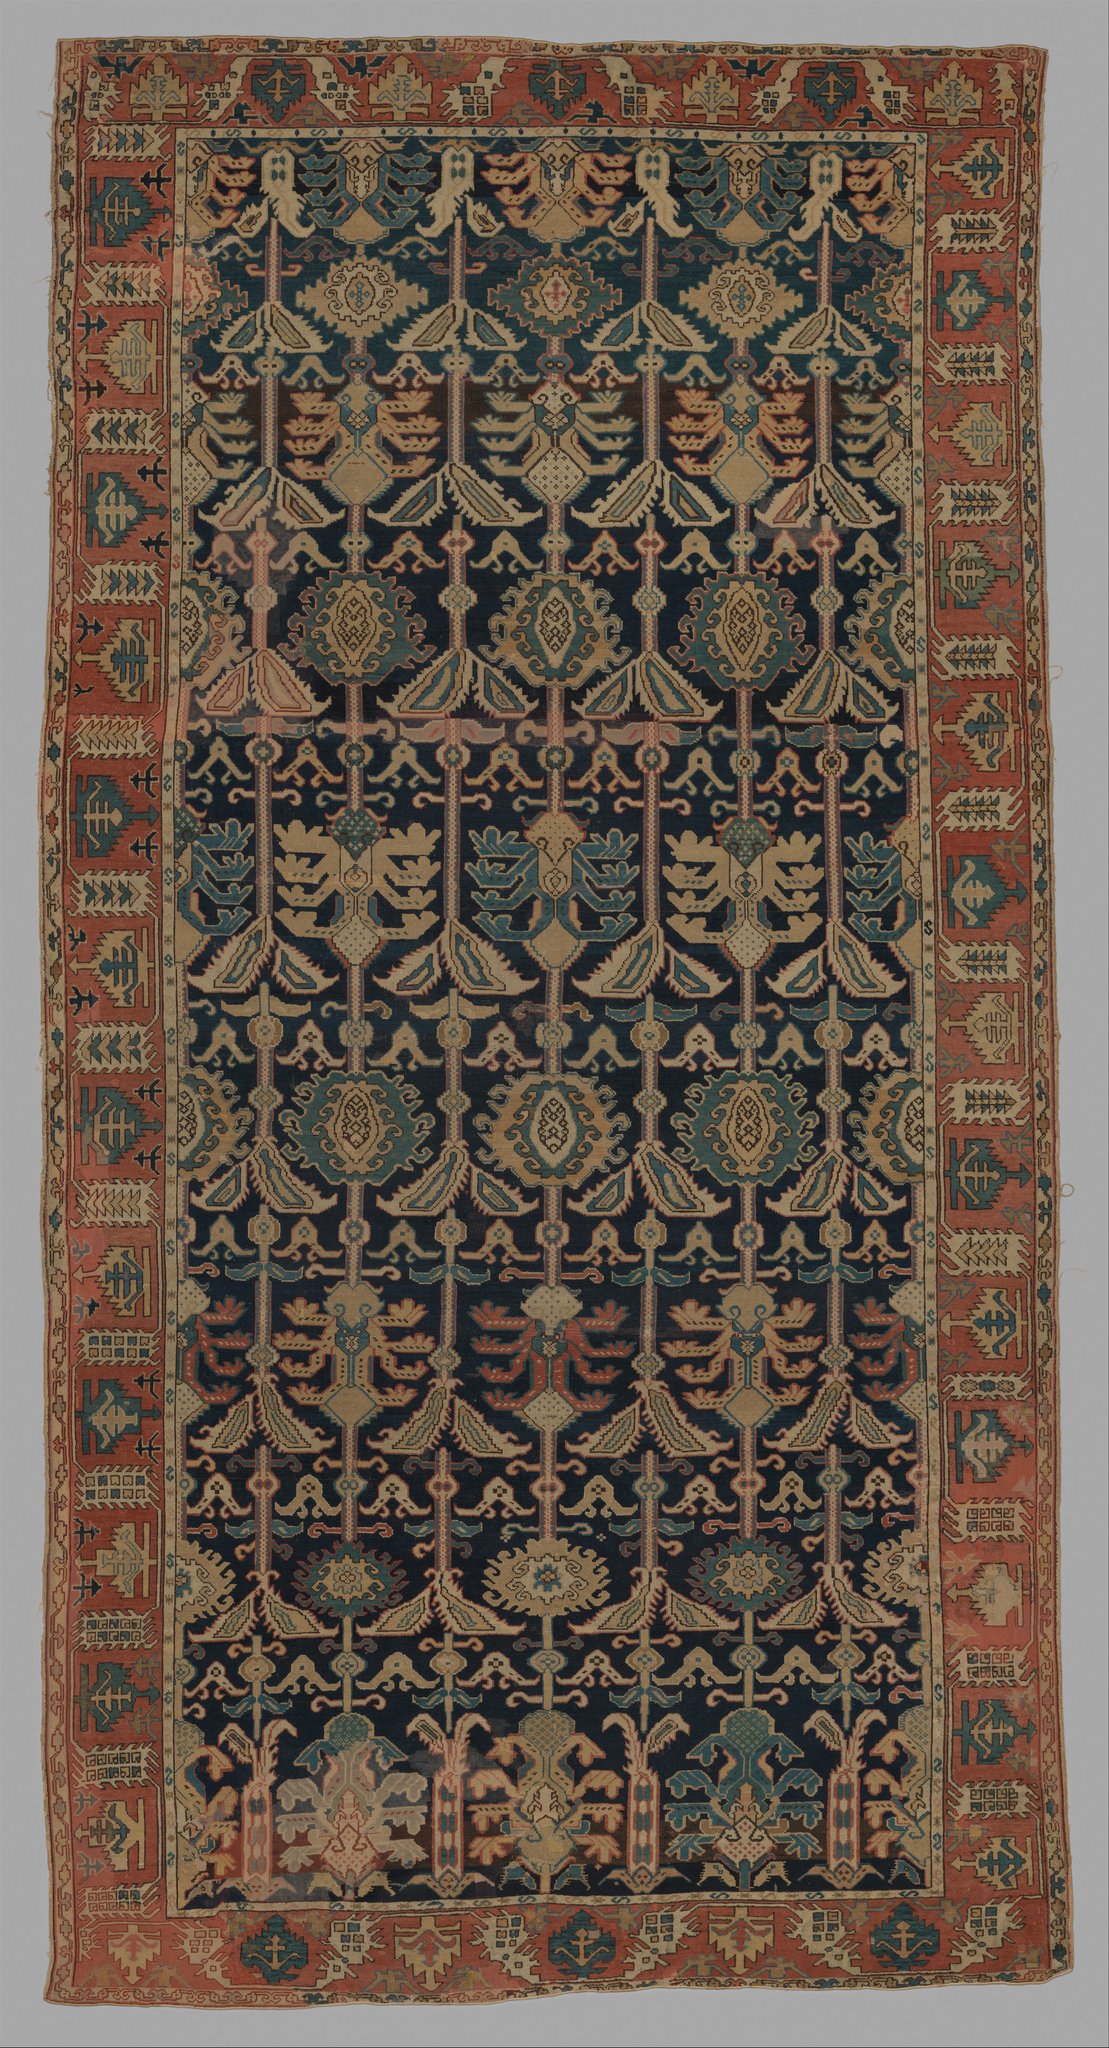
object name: carpet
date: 1801-1833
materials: wool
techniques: pile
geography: caucasus